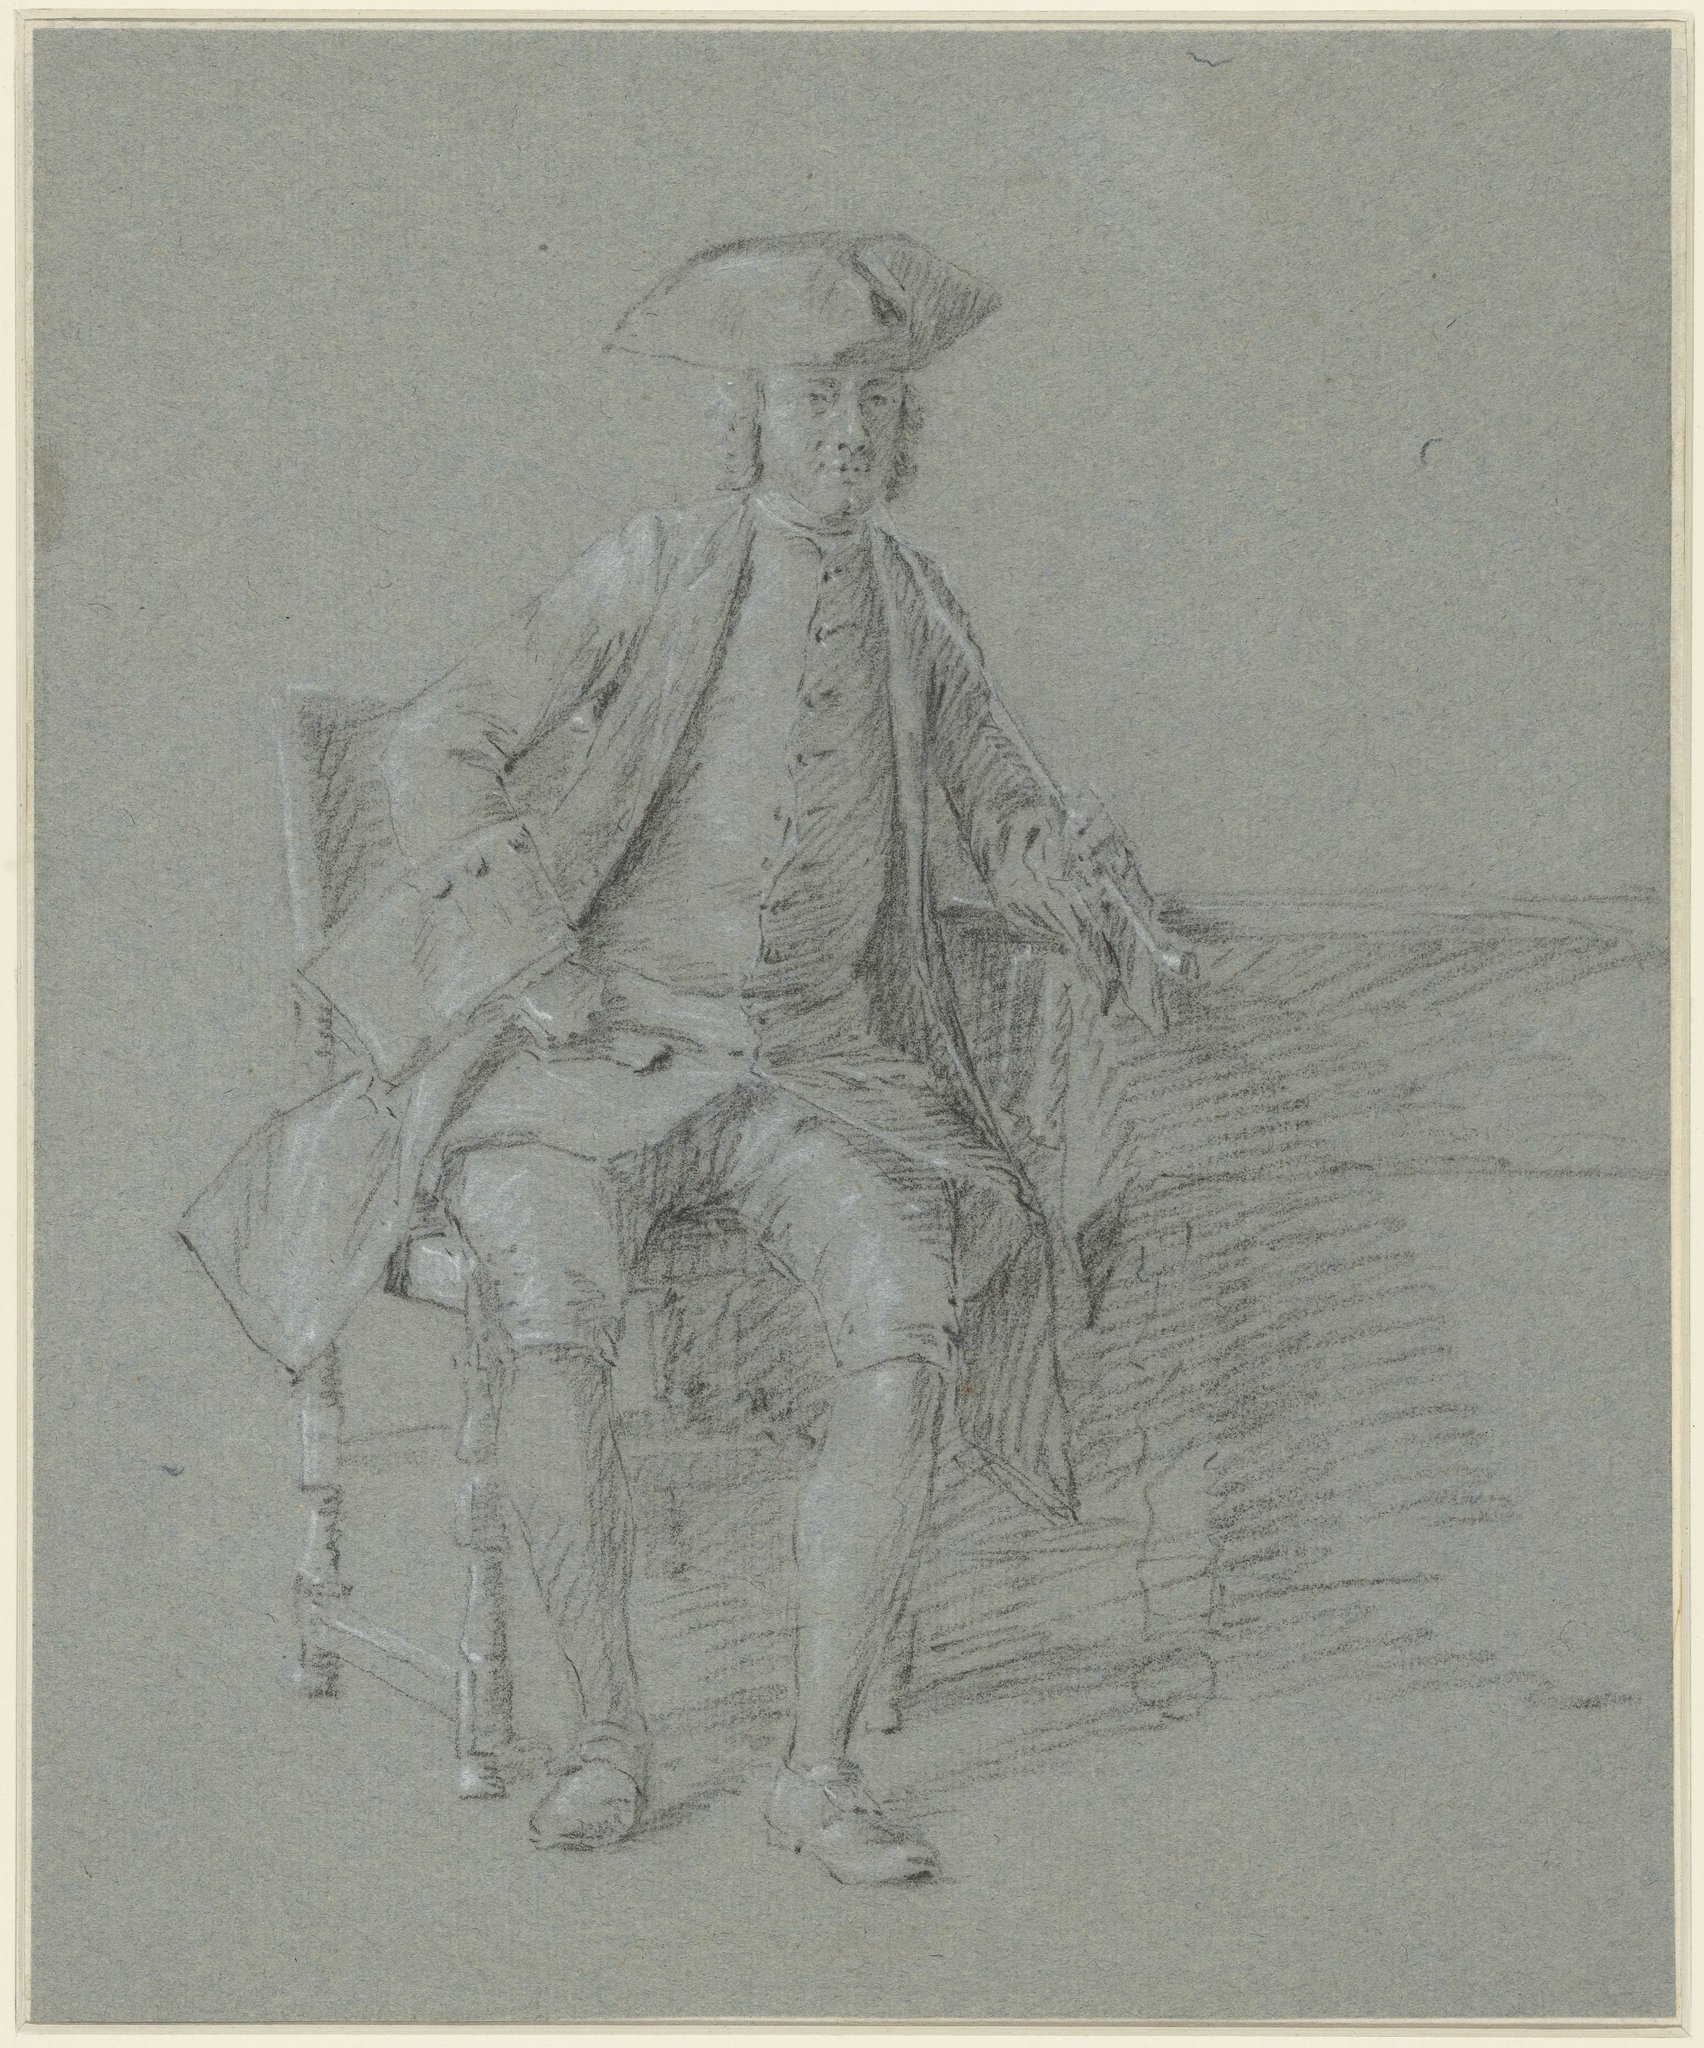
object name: drawing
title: Man met steek met lange pijp in de rechterhand, zittend aan tafel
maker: Anonymous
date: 1700-1800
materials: chalk, paper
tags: sitting figure, pipe ~ tobacco (+ taking (particular) foodstuffs: eating, drinking, smoking, chewing, etc.)